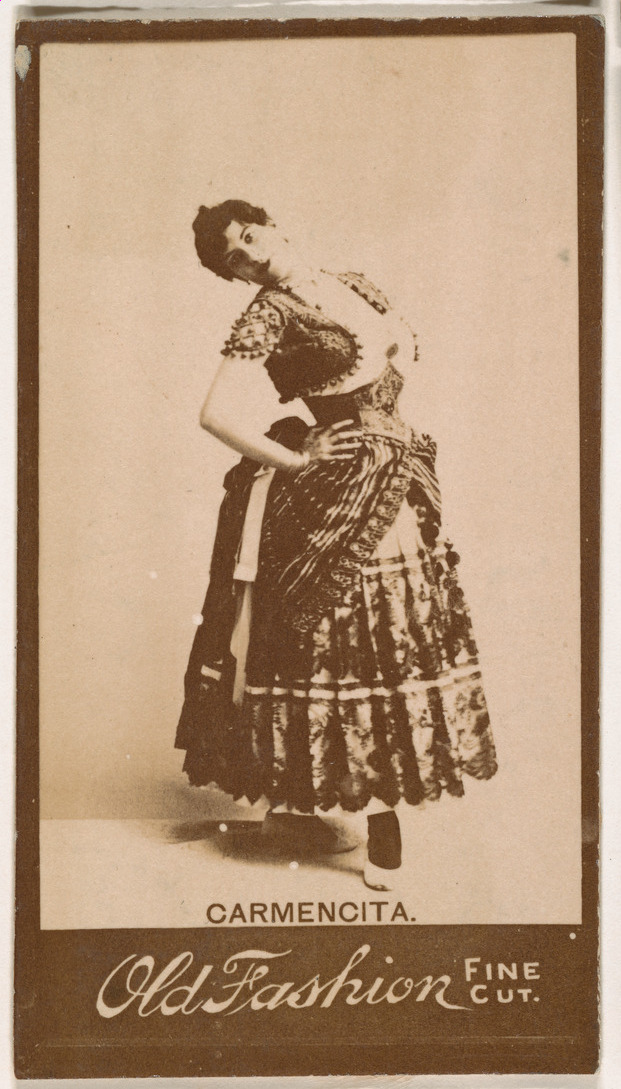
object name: photograph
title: Carmencita, from the Actresses series (N664) promoting Old Fashion Fine Cut Tobacco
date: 1888-1890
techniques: albumen silver print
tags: portraits,women,actresses